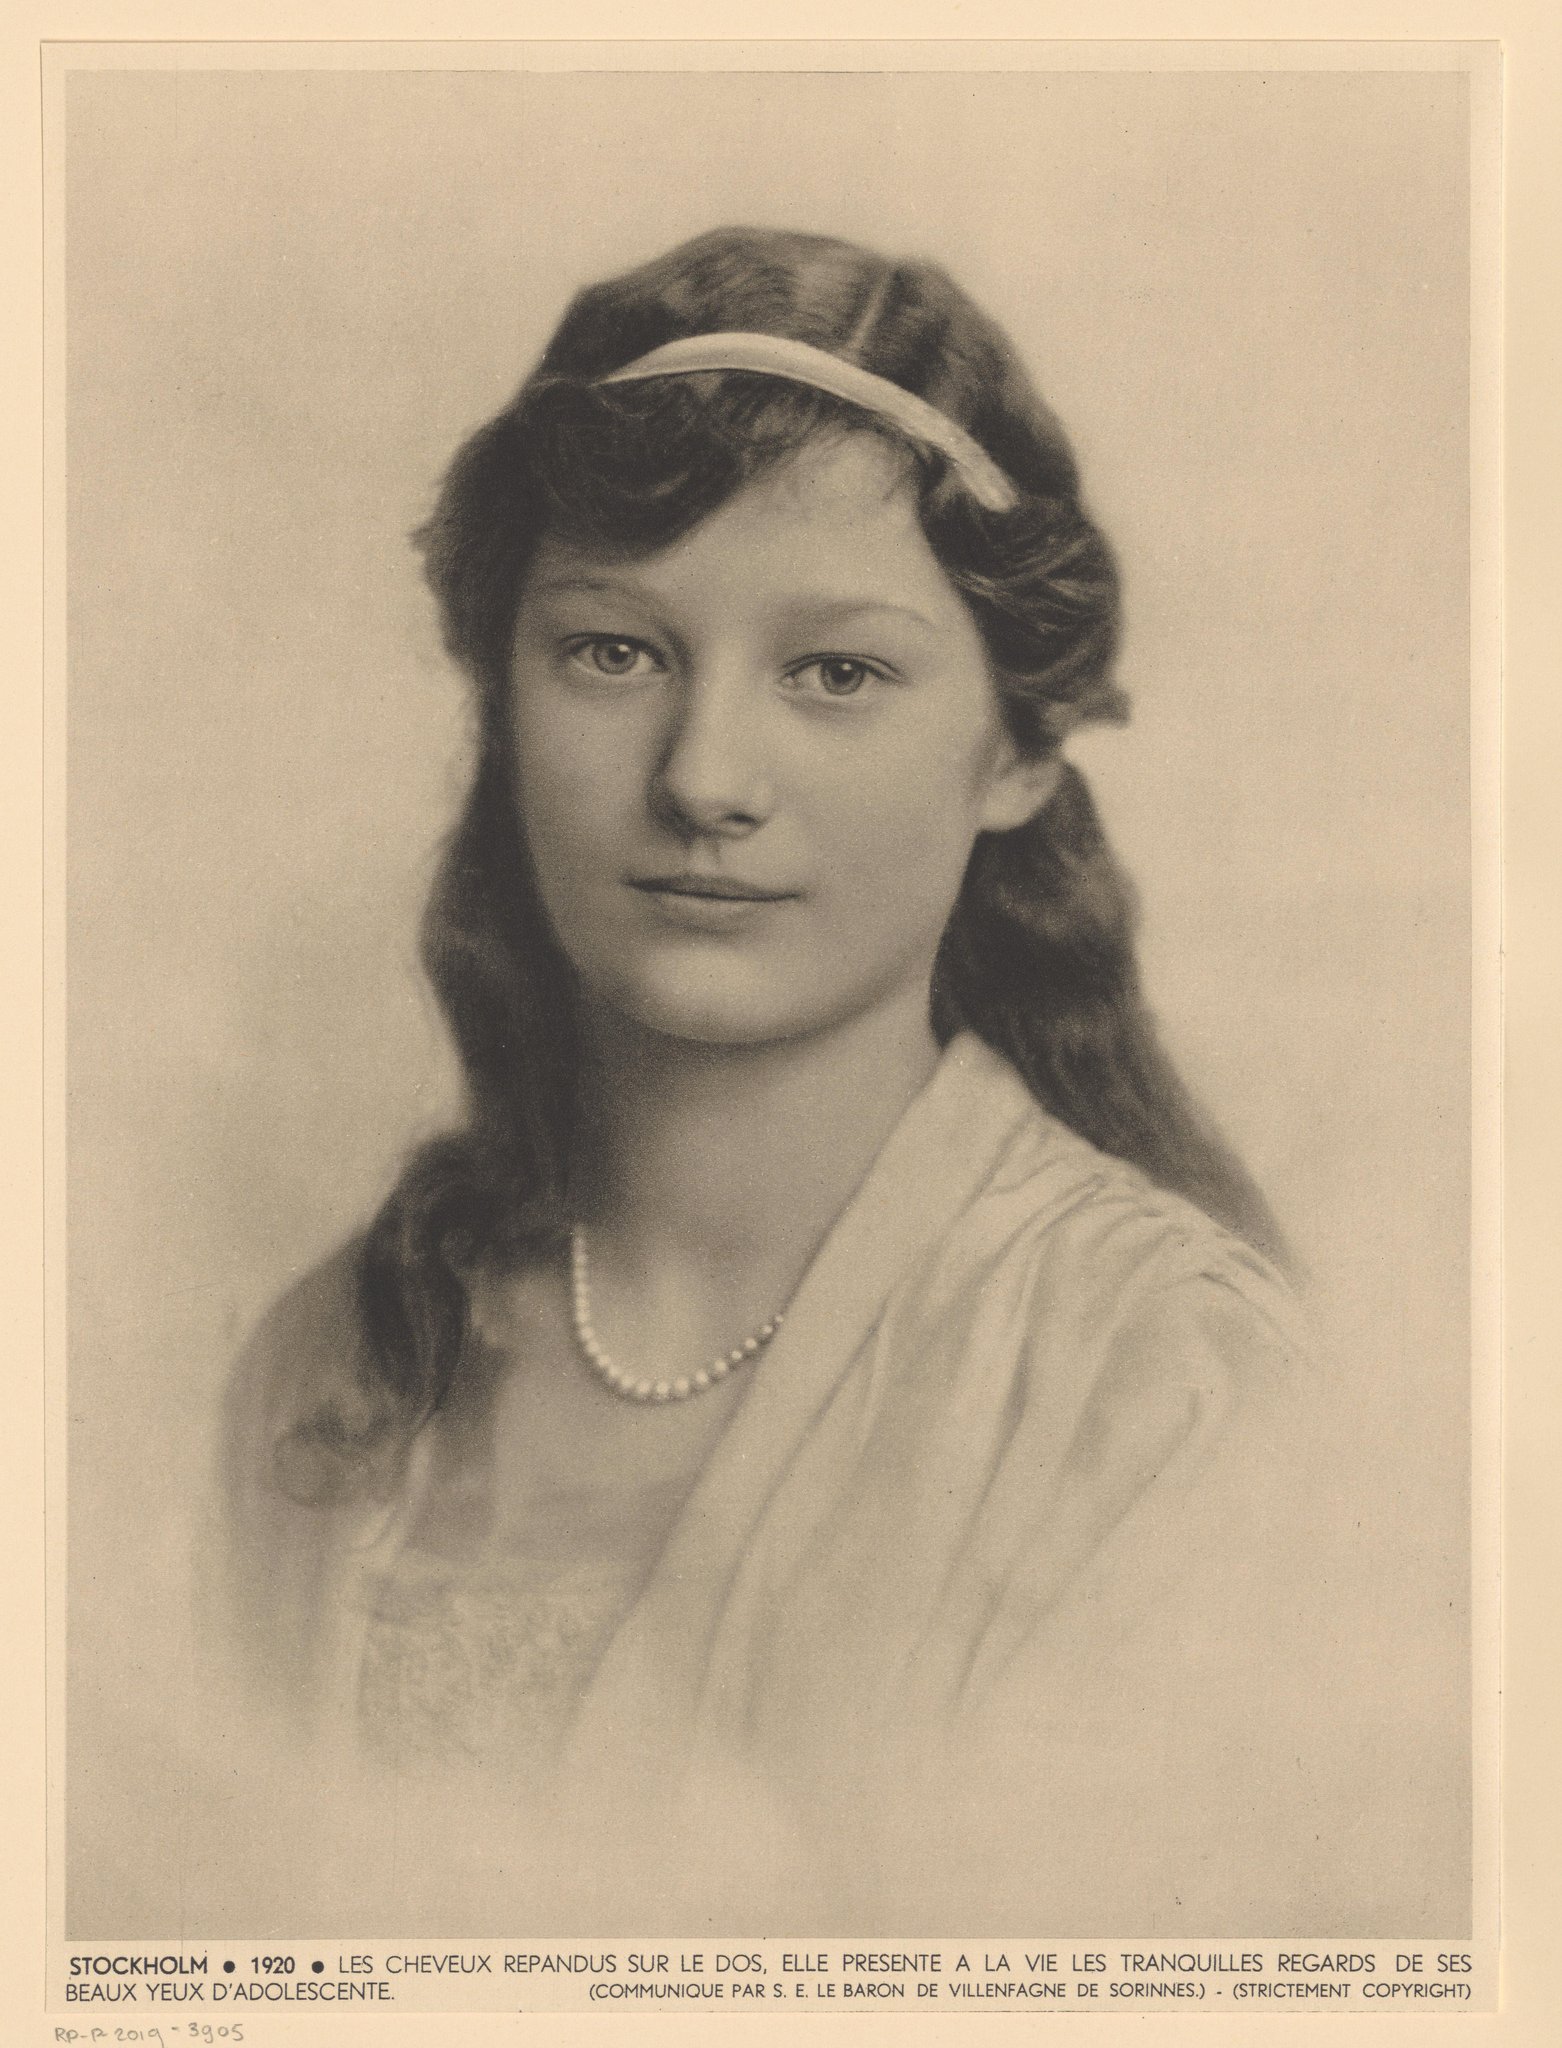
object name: photomechanical print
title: Portret van Astrid van Zweden op 15-jarige leeftijd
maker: Anonymous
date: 1920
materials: paper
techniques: rotogravure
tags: historical persons - bb - woman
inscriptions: date